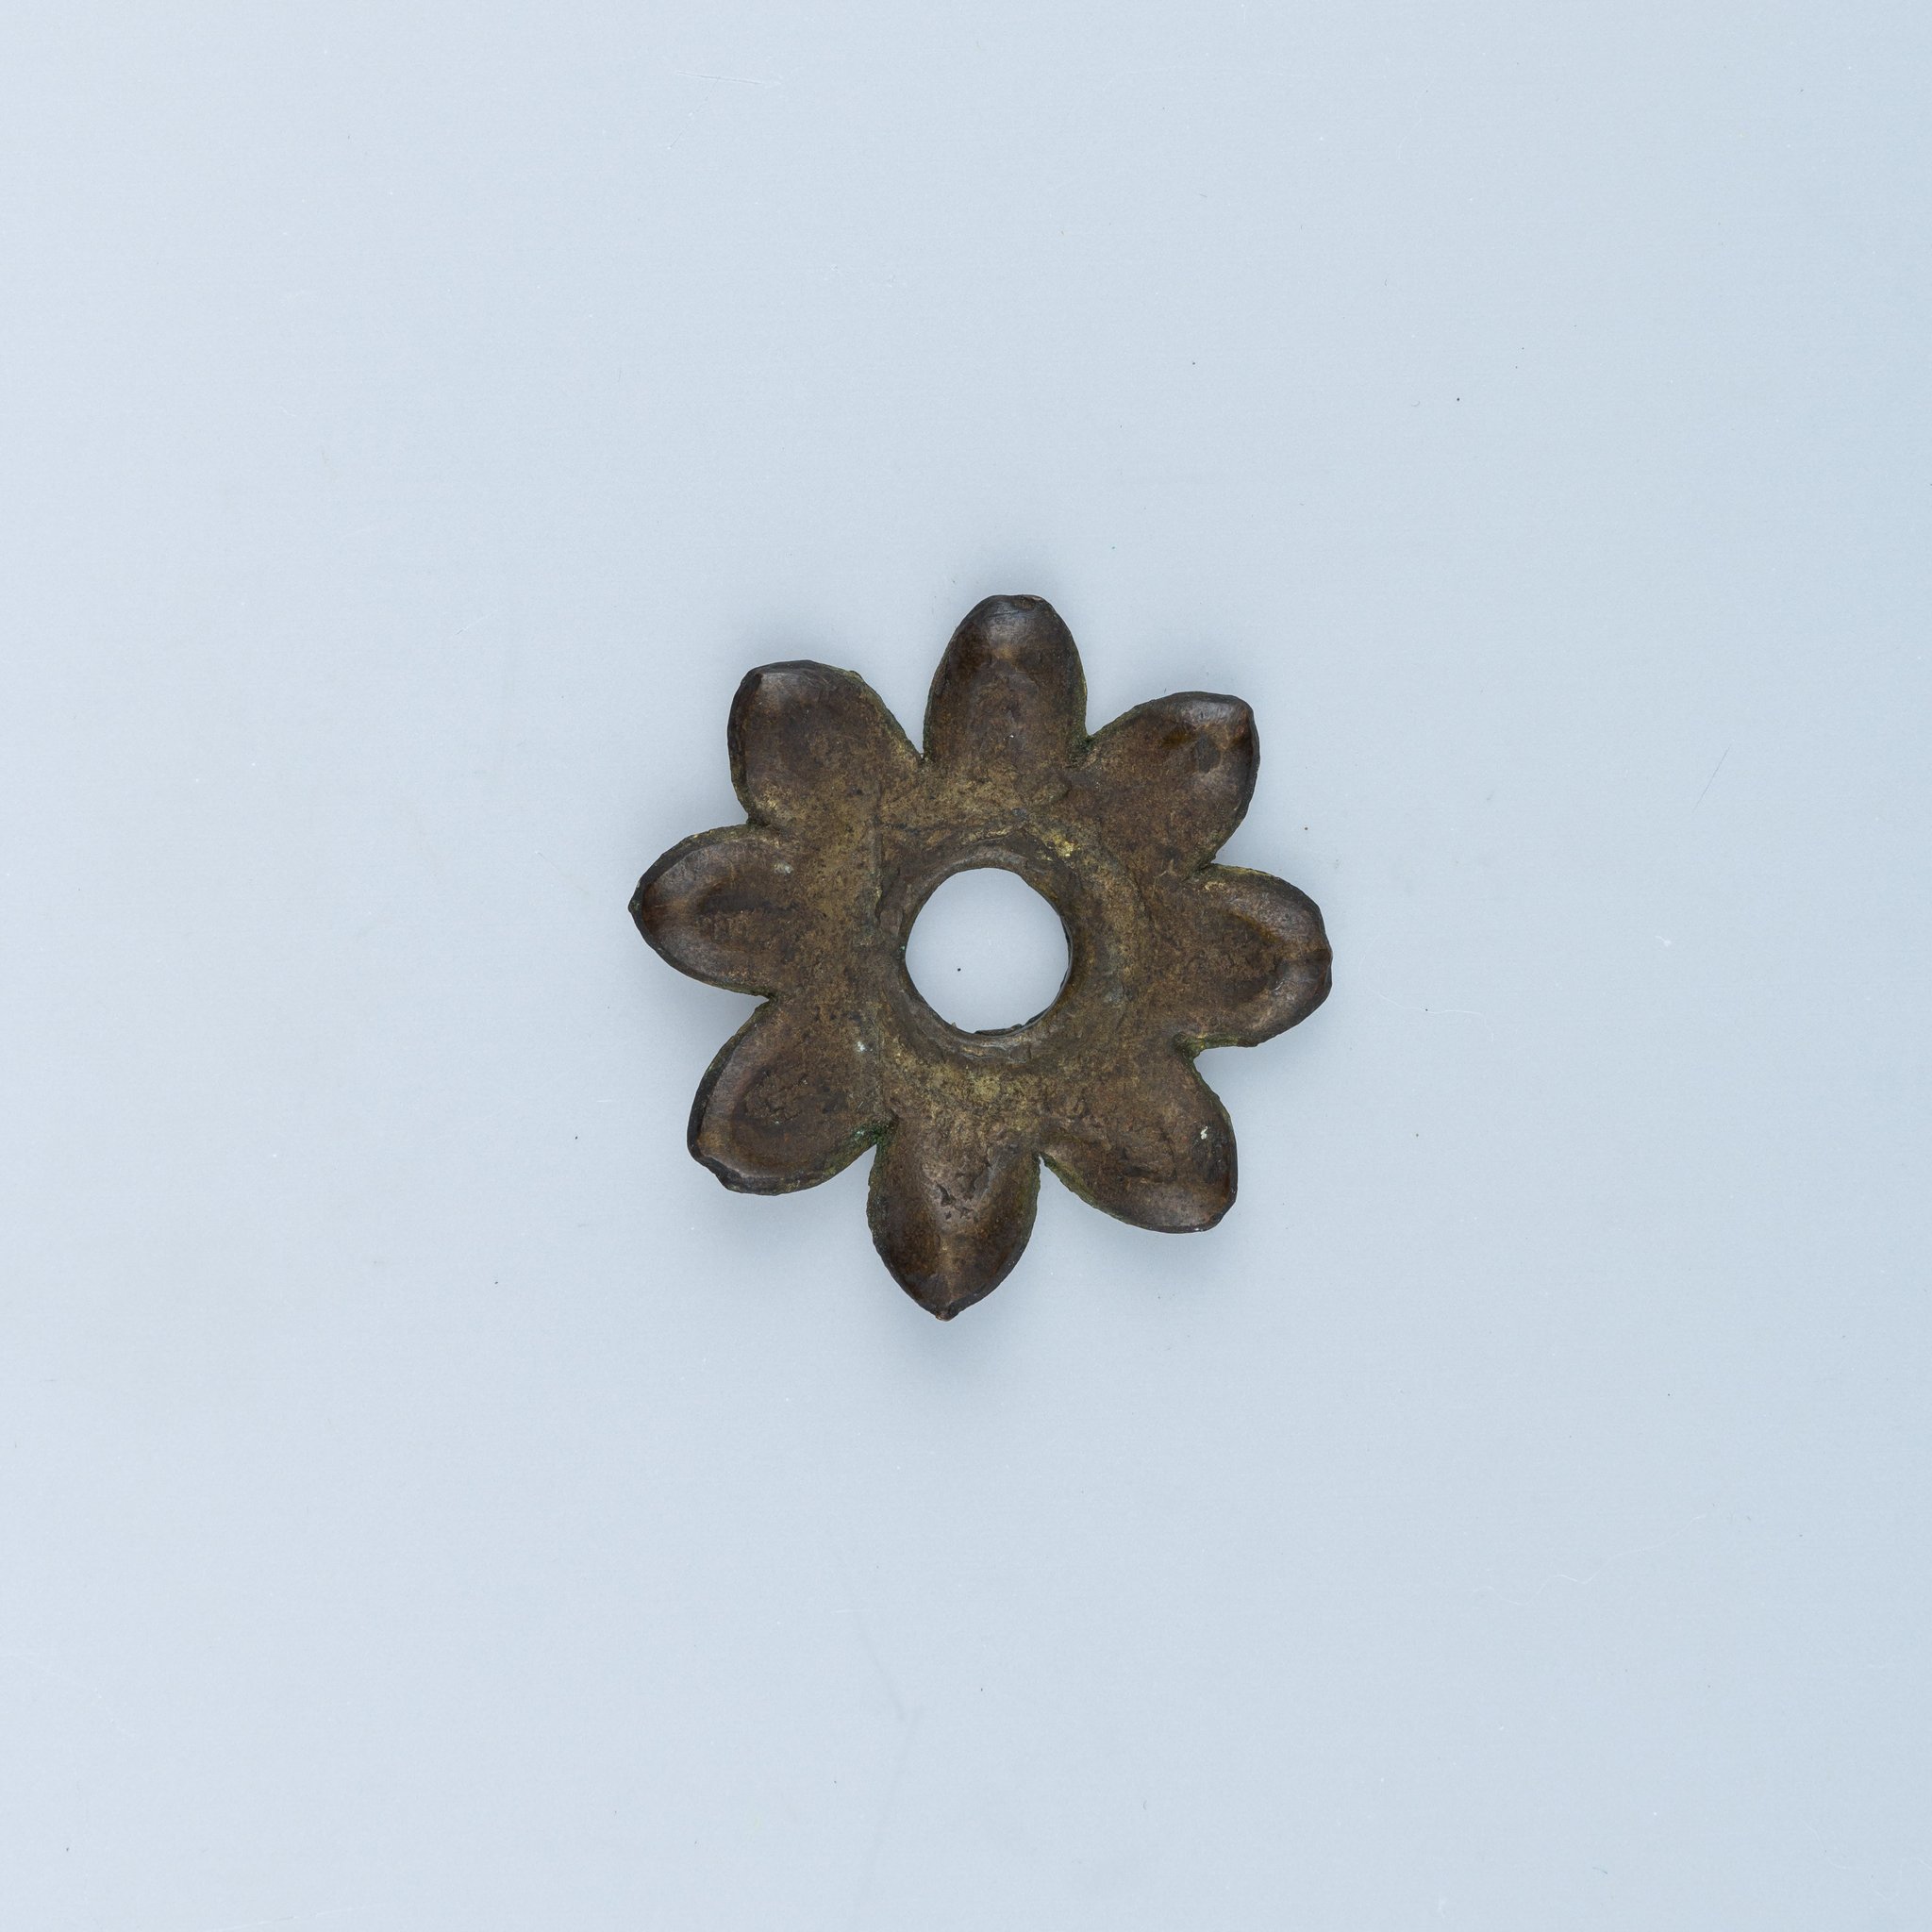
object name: rosette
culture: italian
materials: brass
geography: italy